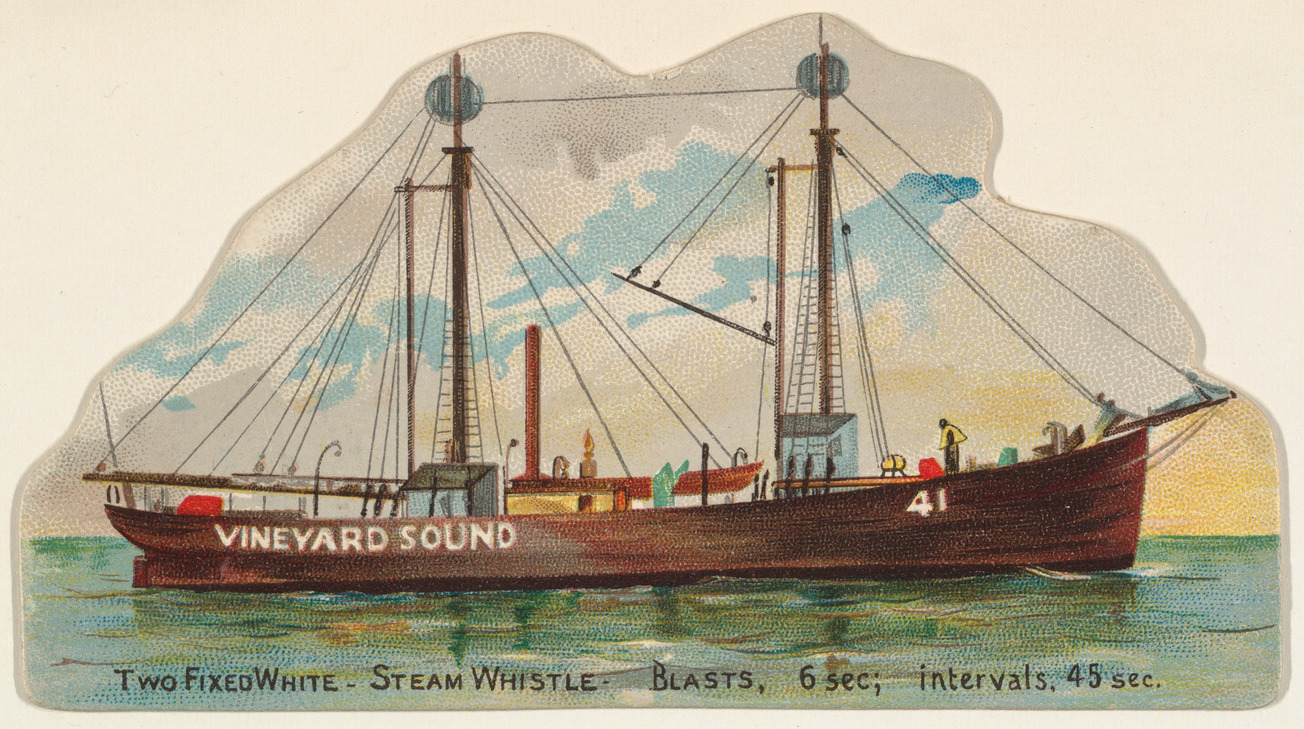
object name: print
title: Vineyard Sound, from the Lighthouses series (N119) issued by Duke Sons & Co. to promote Honest Long Cut Tobacco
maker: w. duke, sons & co.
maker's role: publisher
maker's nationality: american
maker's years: 1870-1920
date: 1889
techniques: color lithograph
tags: ships